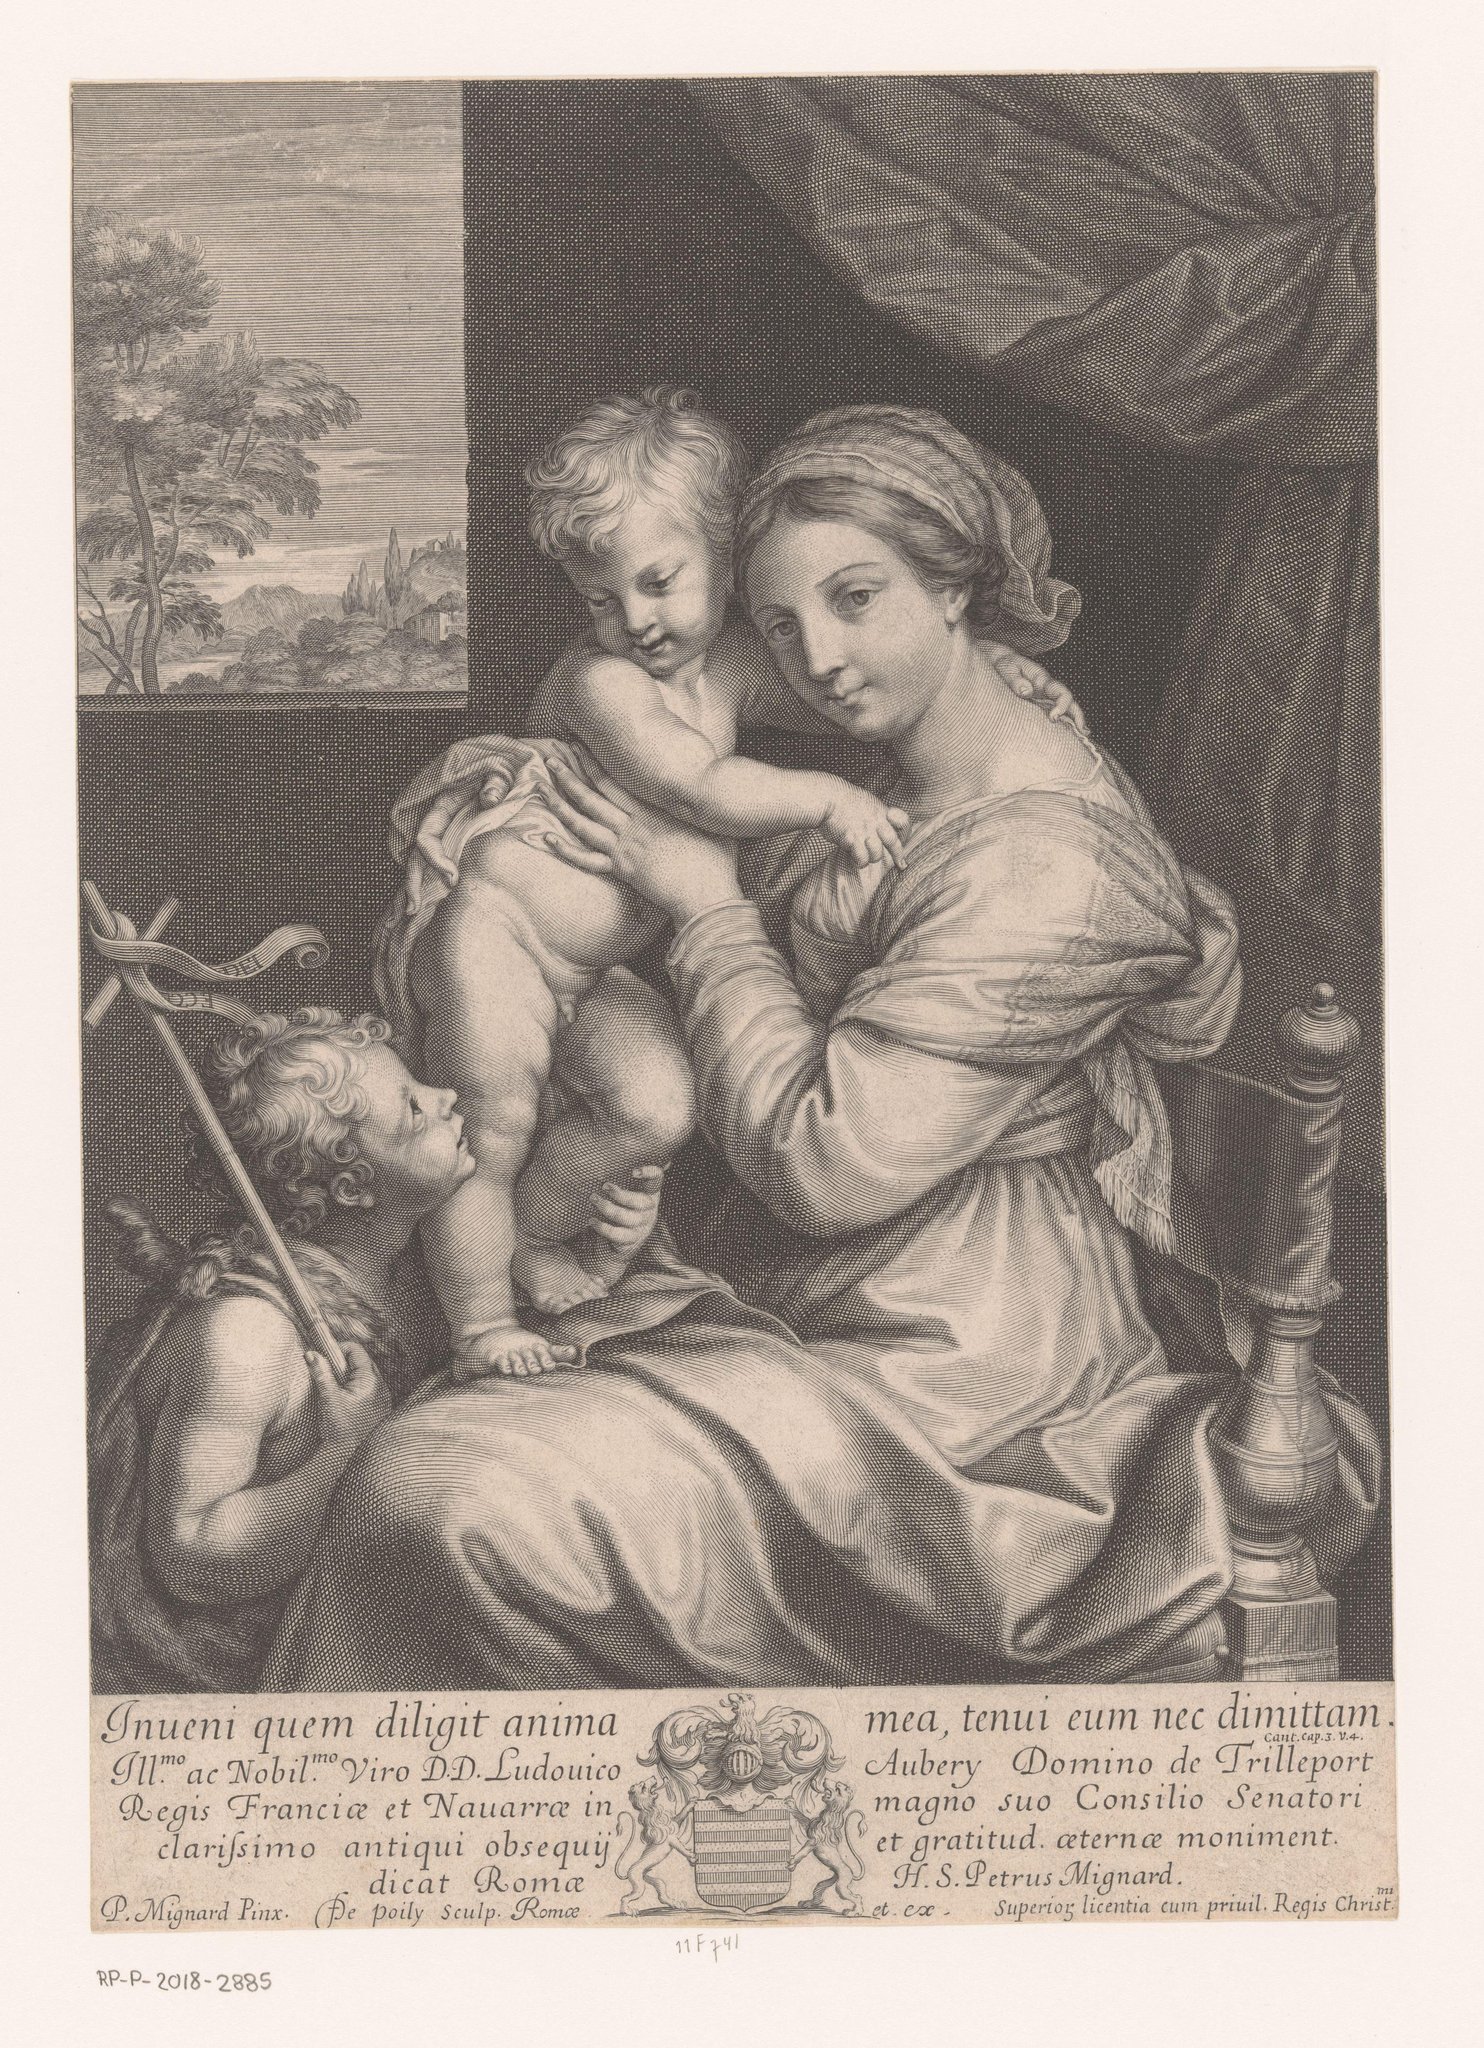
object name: print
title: Maria met kind staand op haar schoot en Johannes de Doper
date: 1632-1693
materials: paper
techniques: engraving, etching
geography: rome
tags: madonna: mary sitting or enthroned, the christ-child in her lap (or in front of her bosom) (mary sometimes represented half-length), john the baptist as child ~ madonna-representations (n.b. secondary notation only)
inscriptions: collector's mark: Lugt 2228, collector's mark: Lugt 2028